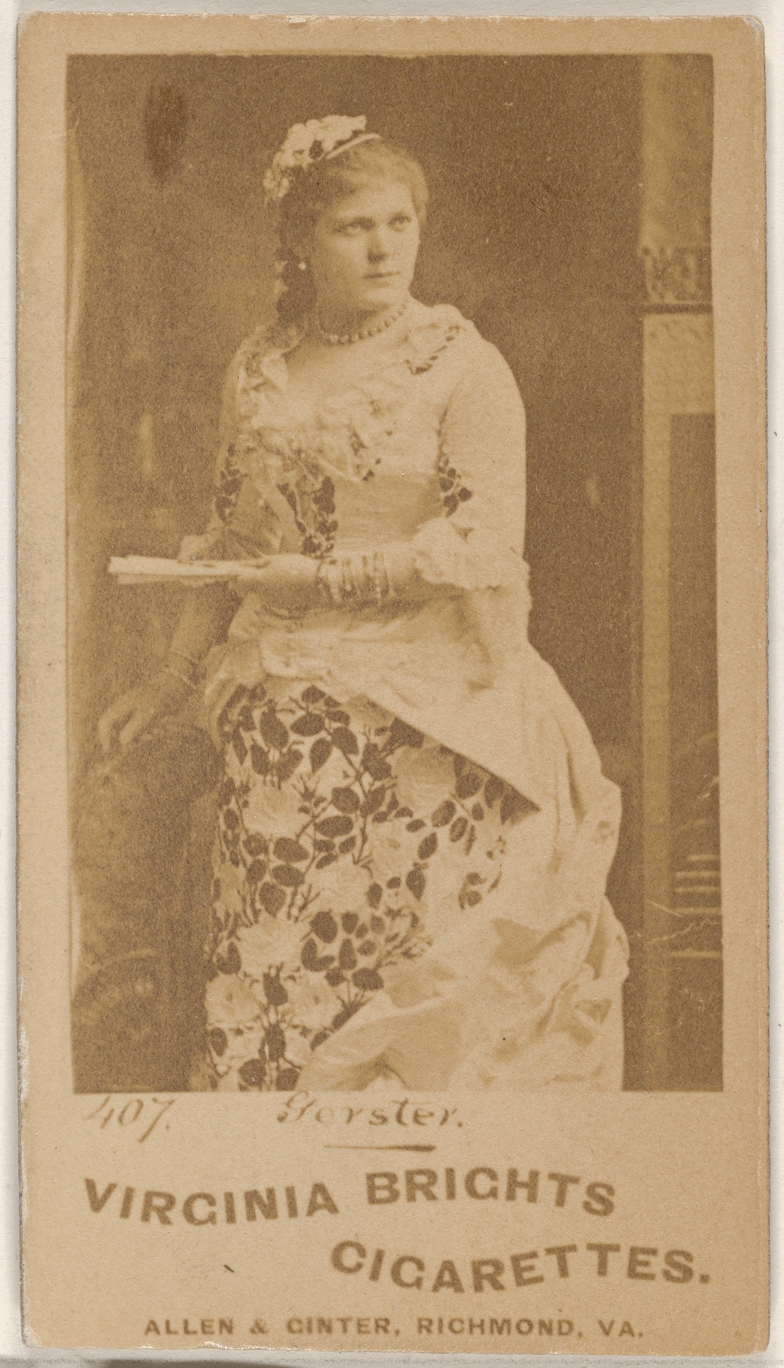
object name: photograph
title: Card 407, Gerster, from the Actors and Actresses series (N45, Type 1) for Virginia Brights Cigarettes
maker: allen & ginter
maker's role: publisher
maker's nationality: american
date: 1888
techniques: albumen silver print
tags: portraits,women,actresses